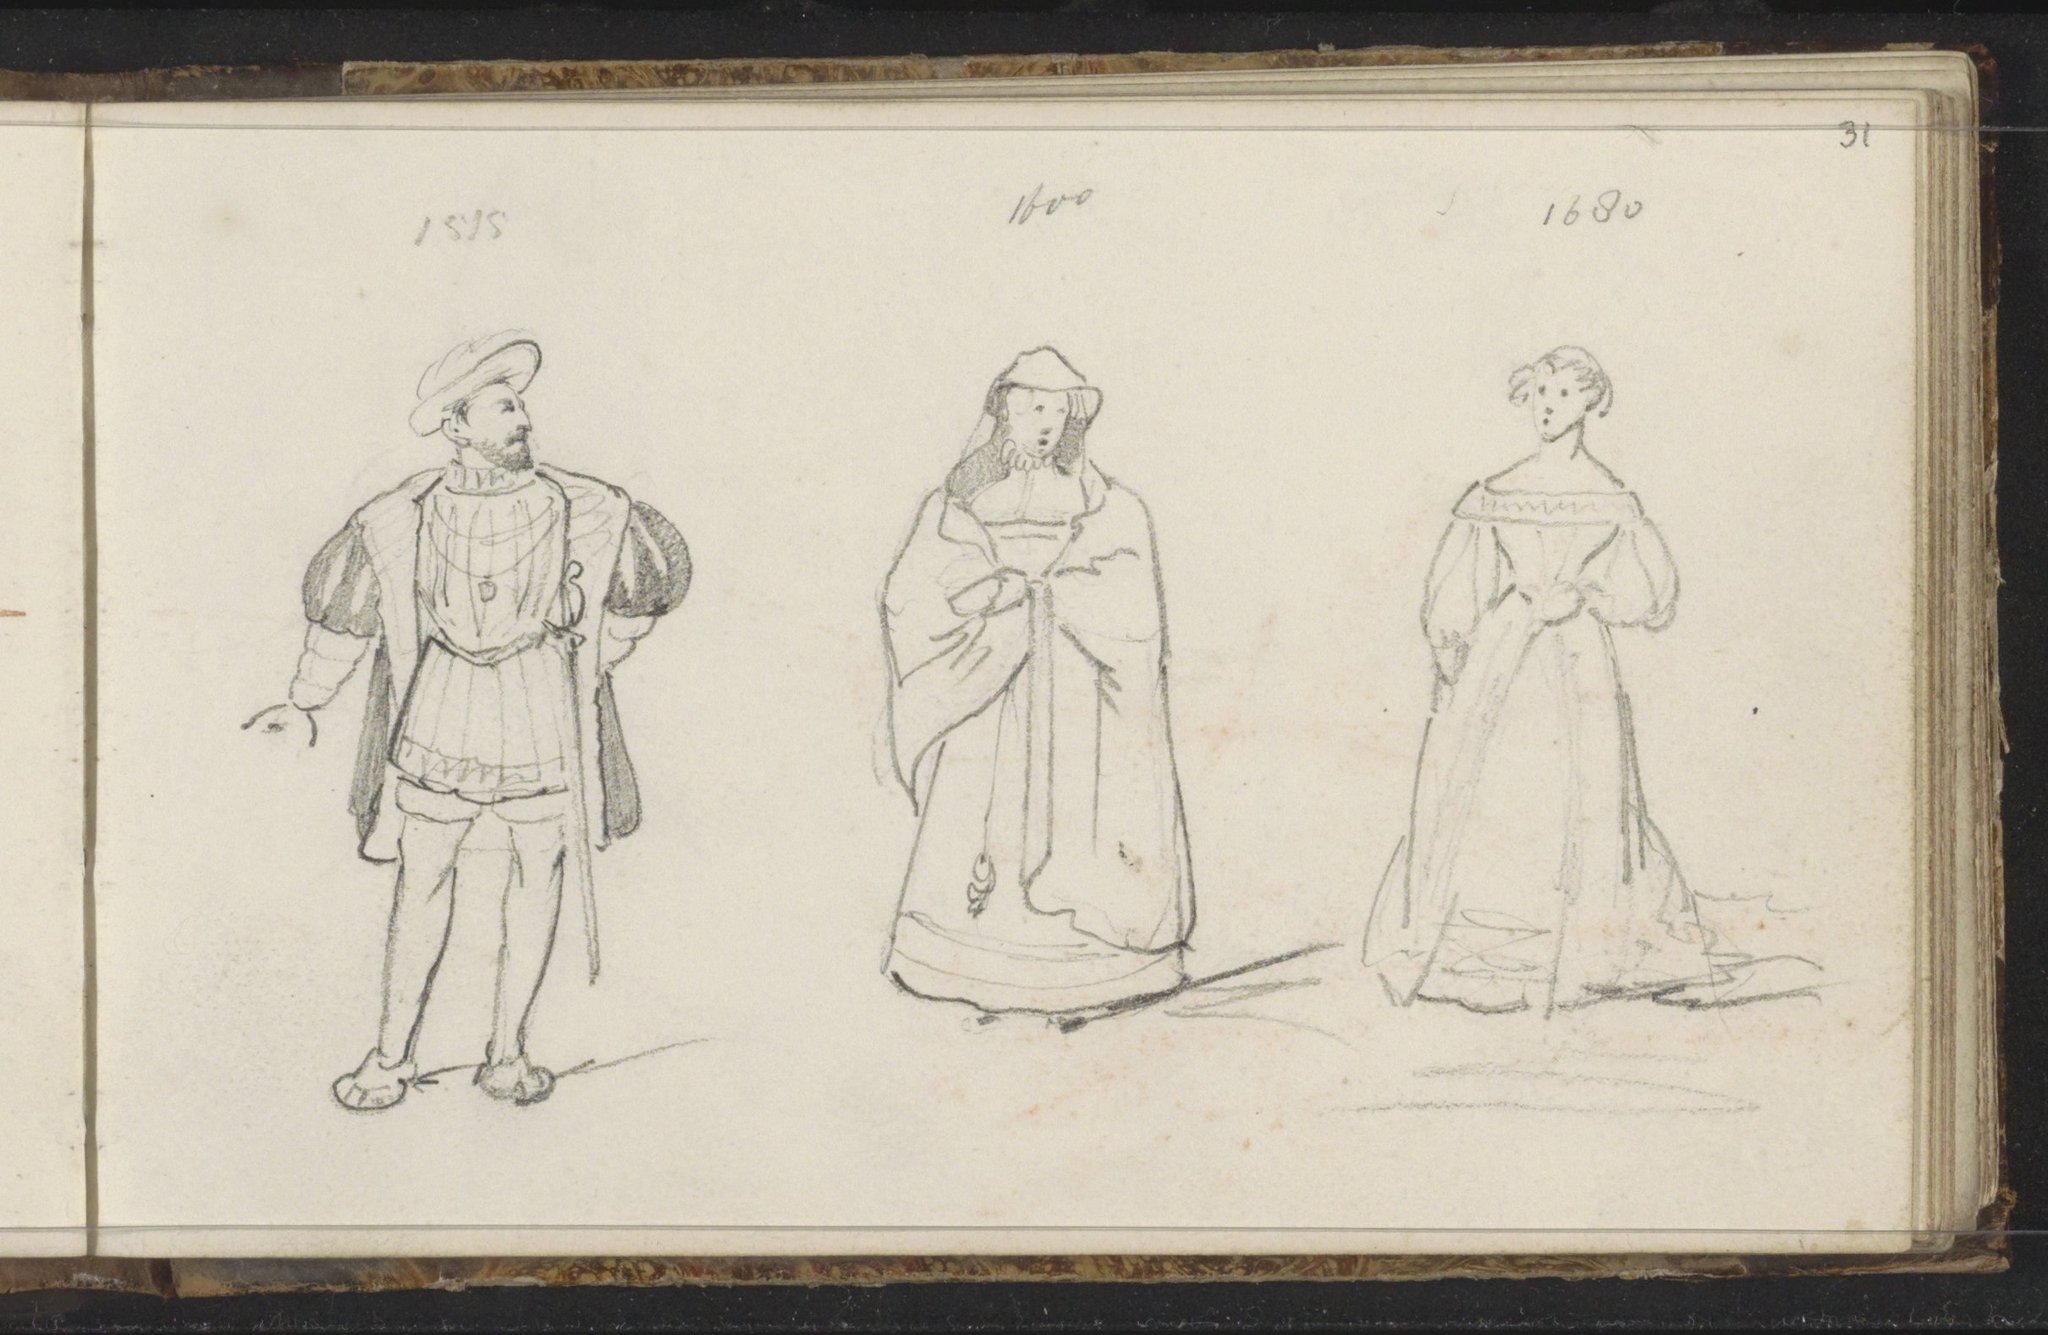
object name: sketchbook leaf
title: Man en twee vrouwen in historisch kostuum uit de periode 1515-1680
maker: willem hendrik schmidt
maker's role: draughtsman, painter, print maker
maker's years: 1809-1849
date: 1819-1849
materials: paper, pencil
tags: historical costume (+ men's clothes), historical costume (+ women's clothes)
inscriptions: annotation: ‘1515 1600 1680’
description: Blad 31 recto uit een schetsboek met 60 bladen.